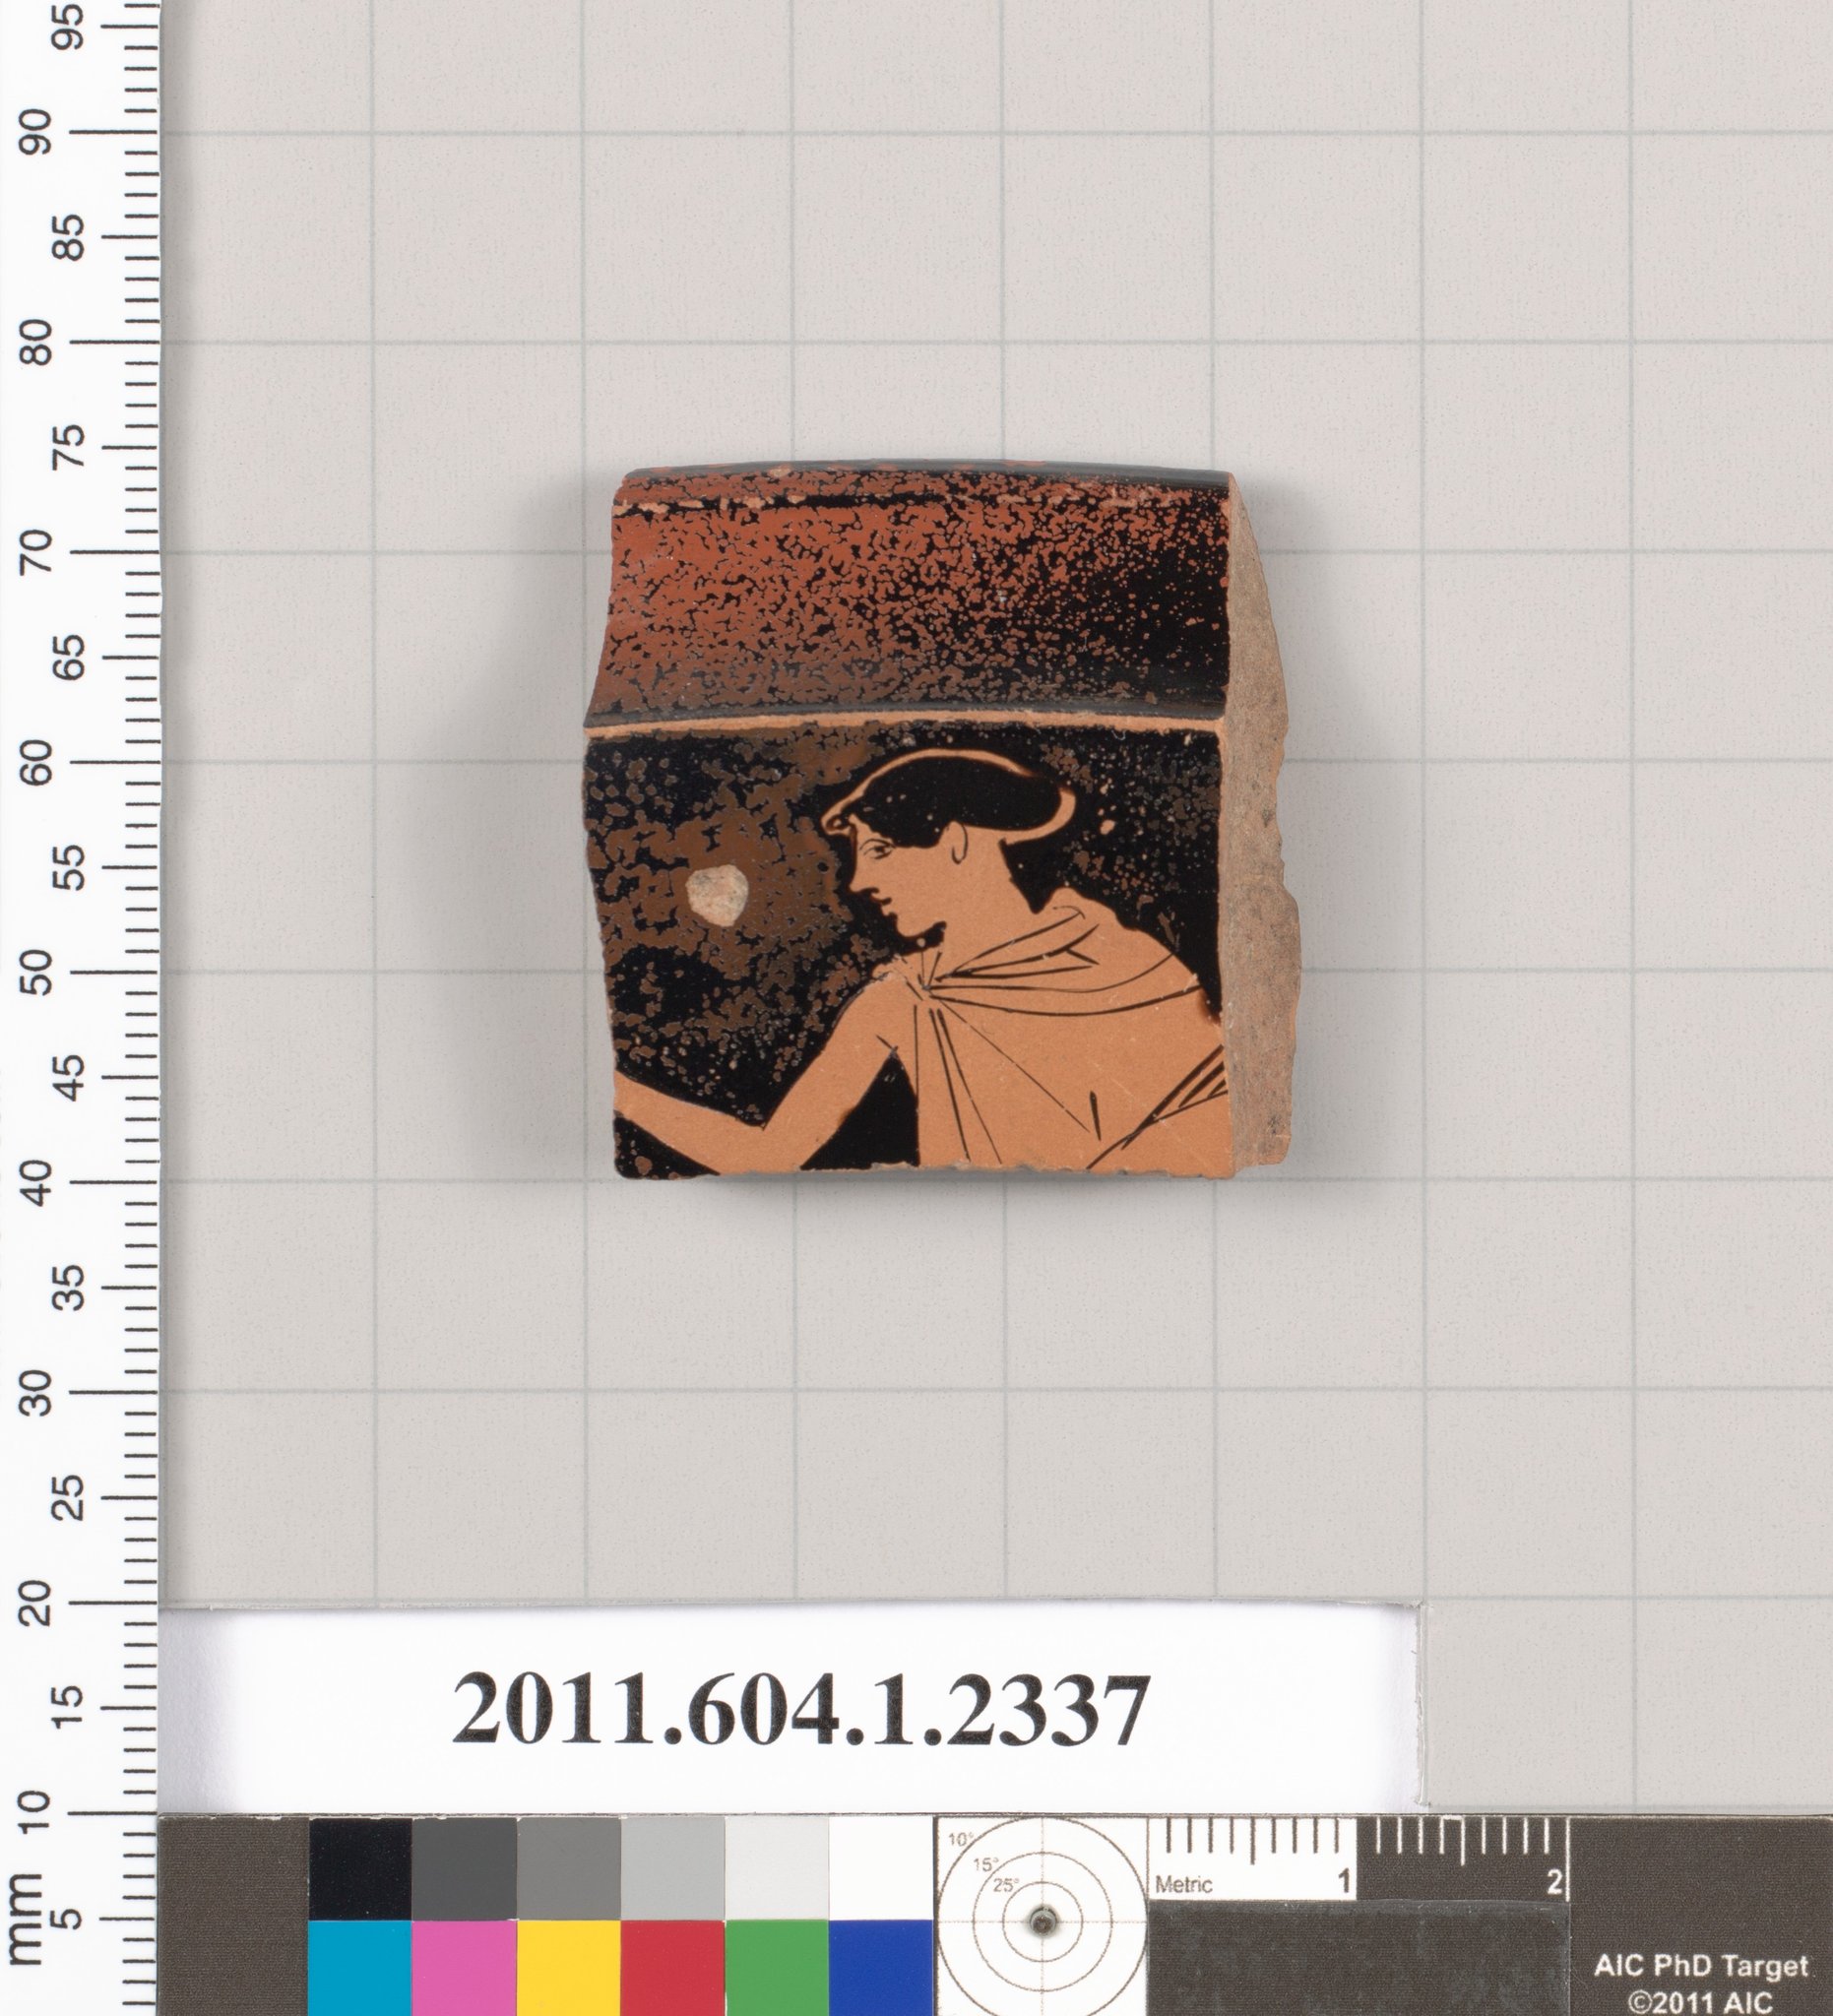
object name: kylix fragment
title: Terracotta rim fragment of a kylix (drinking cup)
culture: greek, attic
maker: carlsruhe painter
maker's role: artist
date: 460-450 BCE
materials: terracotta